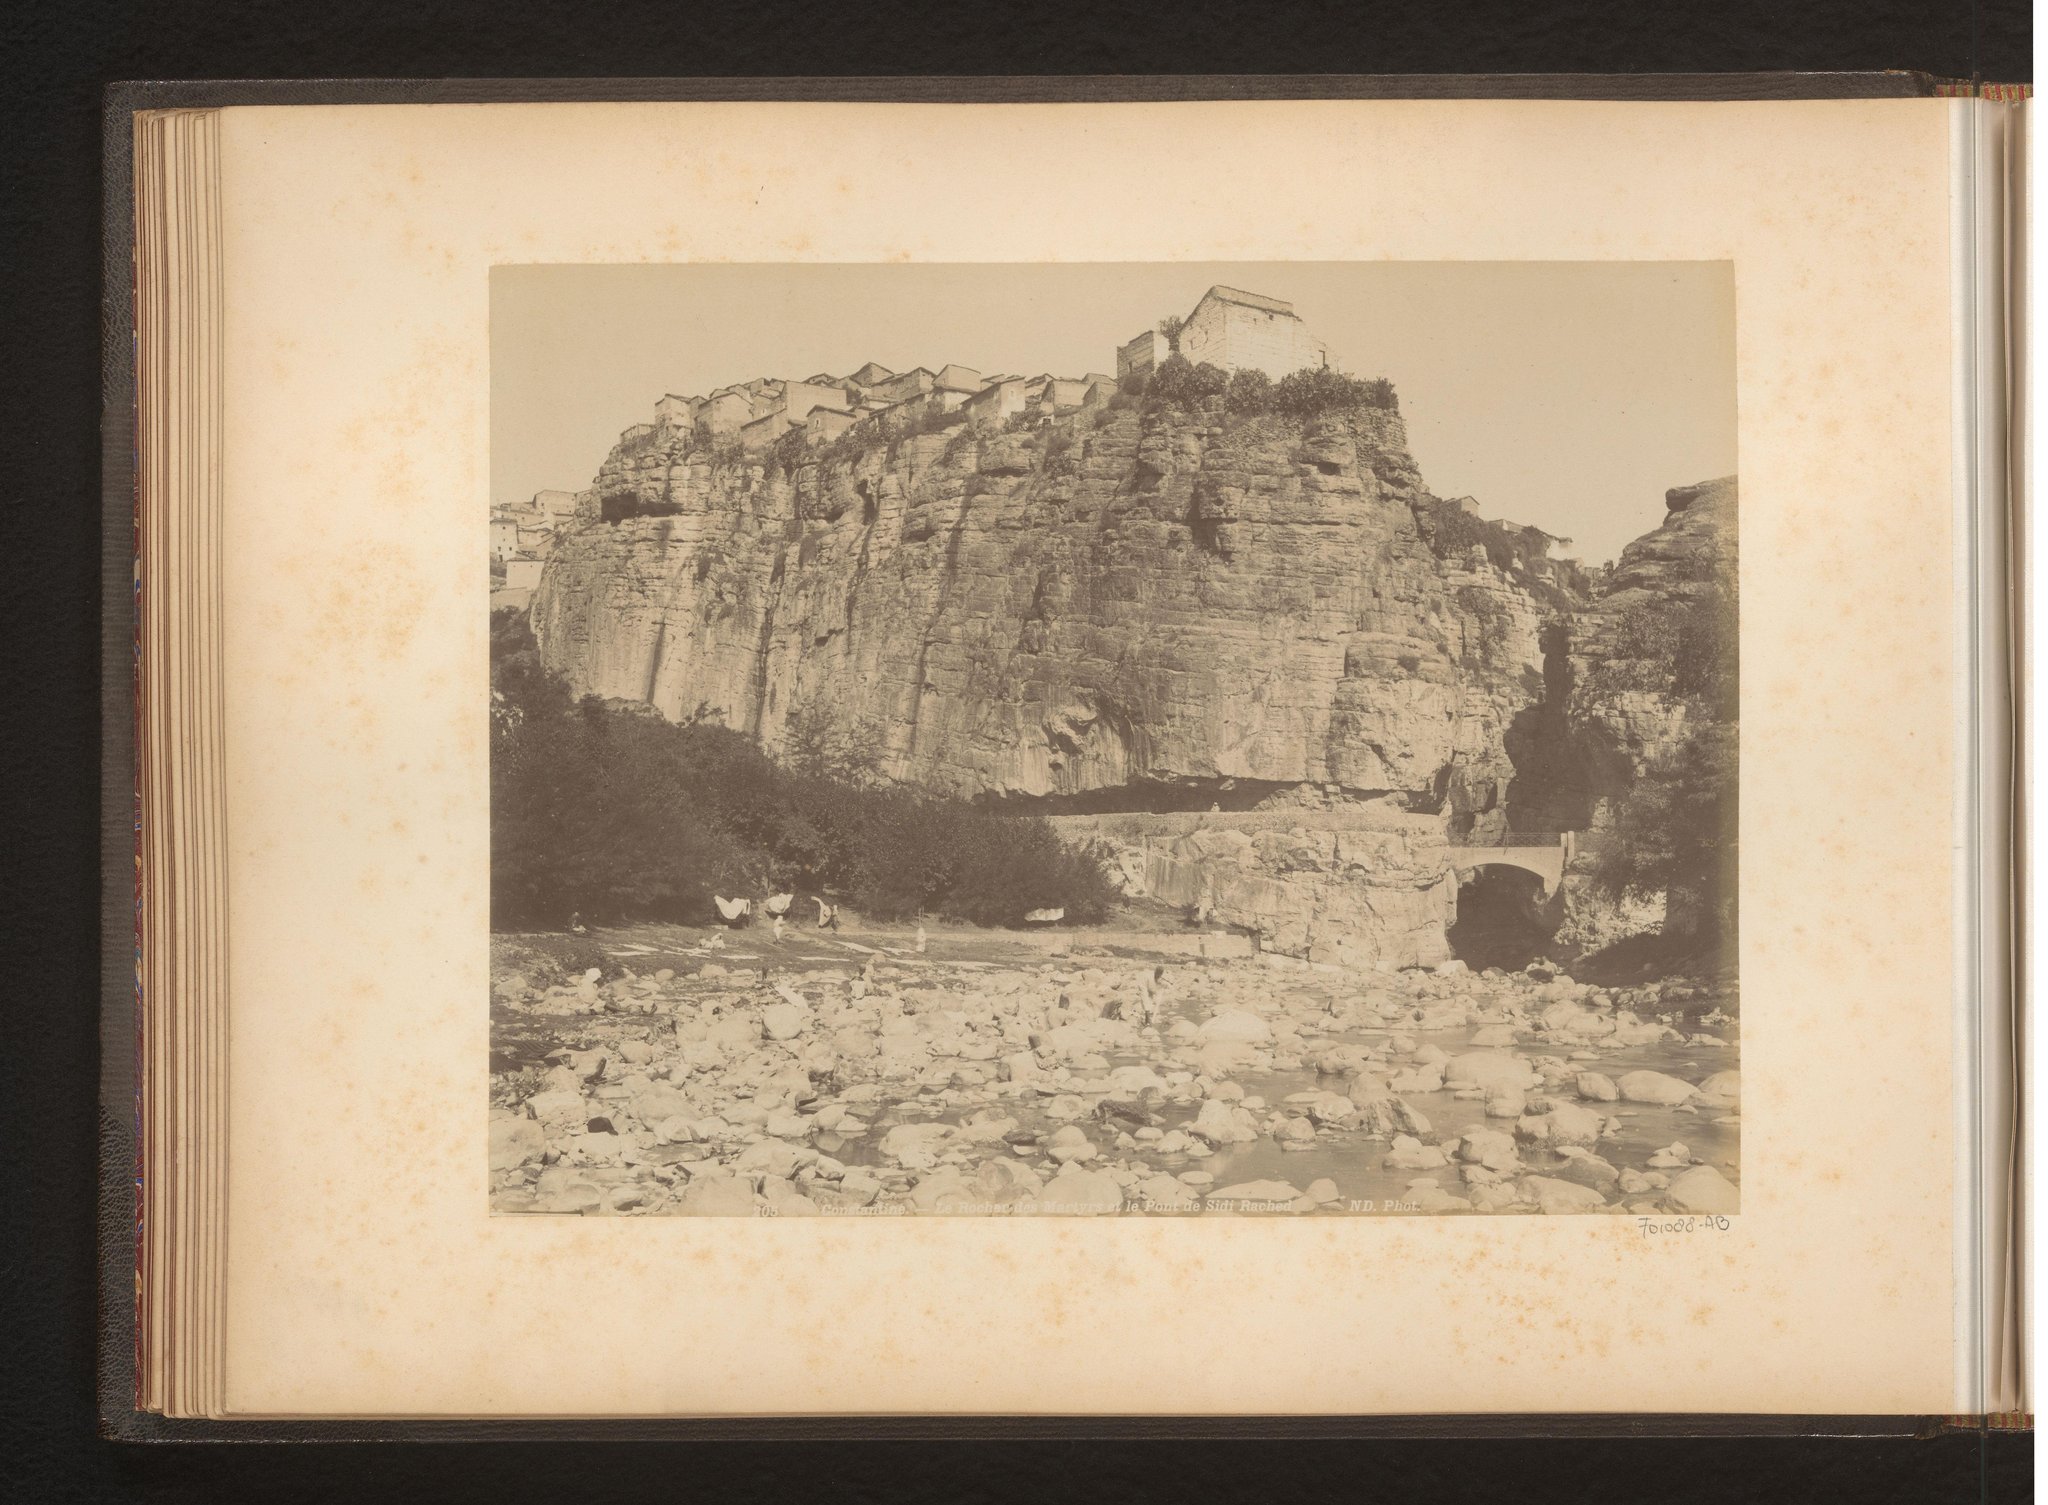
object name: album leaf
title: Gezicht op een brug en rotsen bij Constantine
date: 1880-1900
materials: photographic support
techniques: albumen print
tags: city-view, and landscape with man-made constructions, rock-formations, bridge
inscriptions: number: ‘205’, check stamp: ‘J. Kuhn Editeur/ 220 Rue de Rivoli Paris’